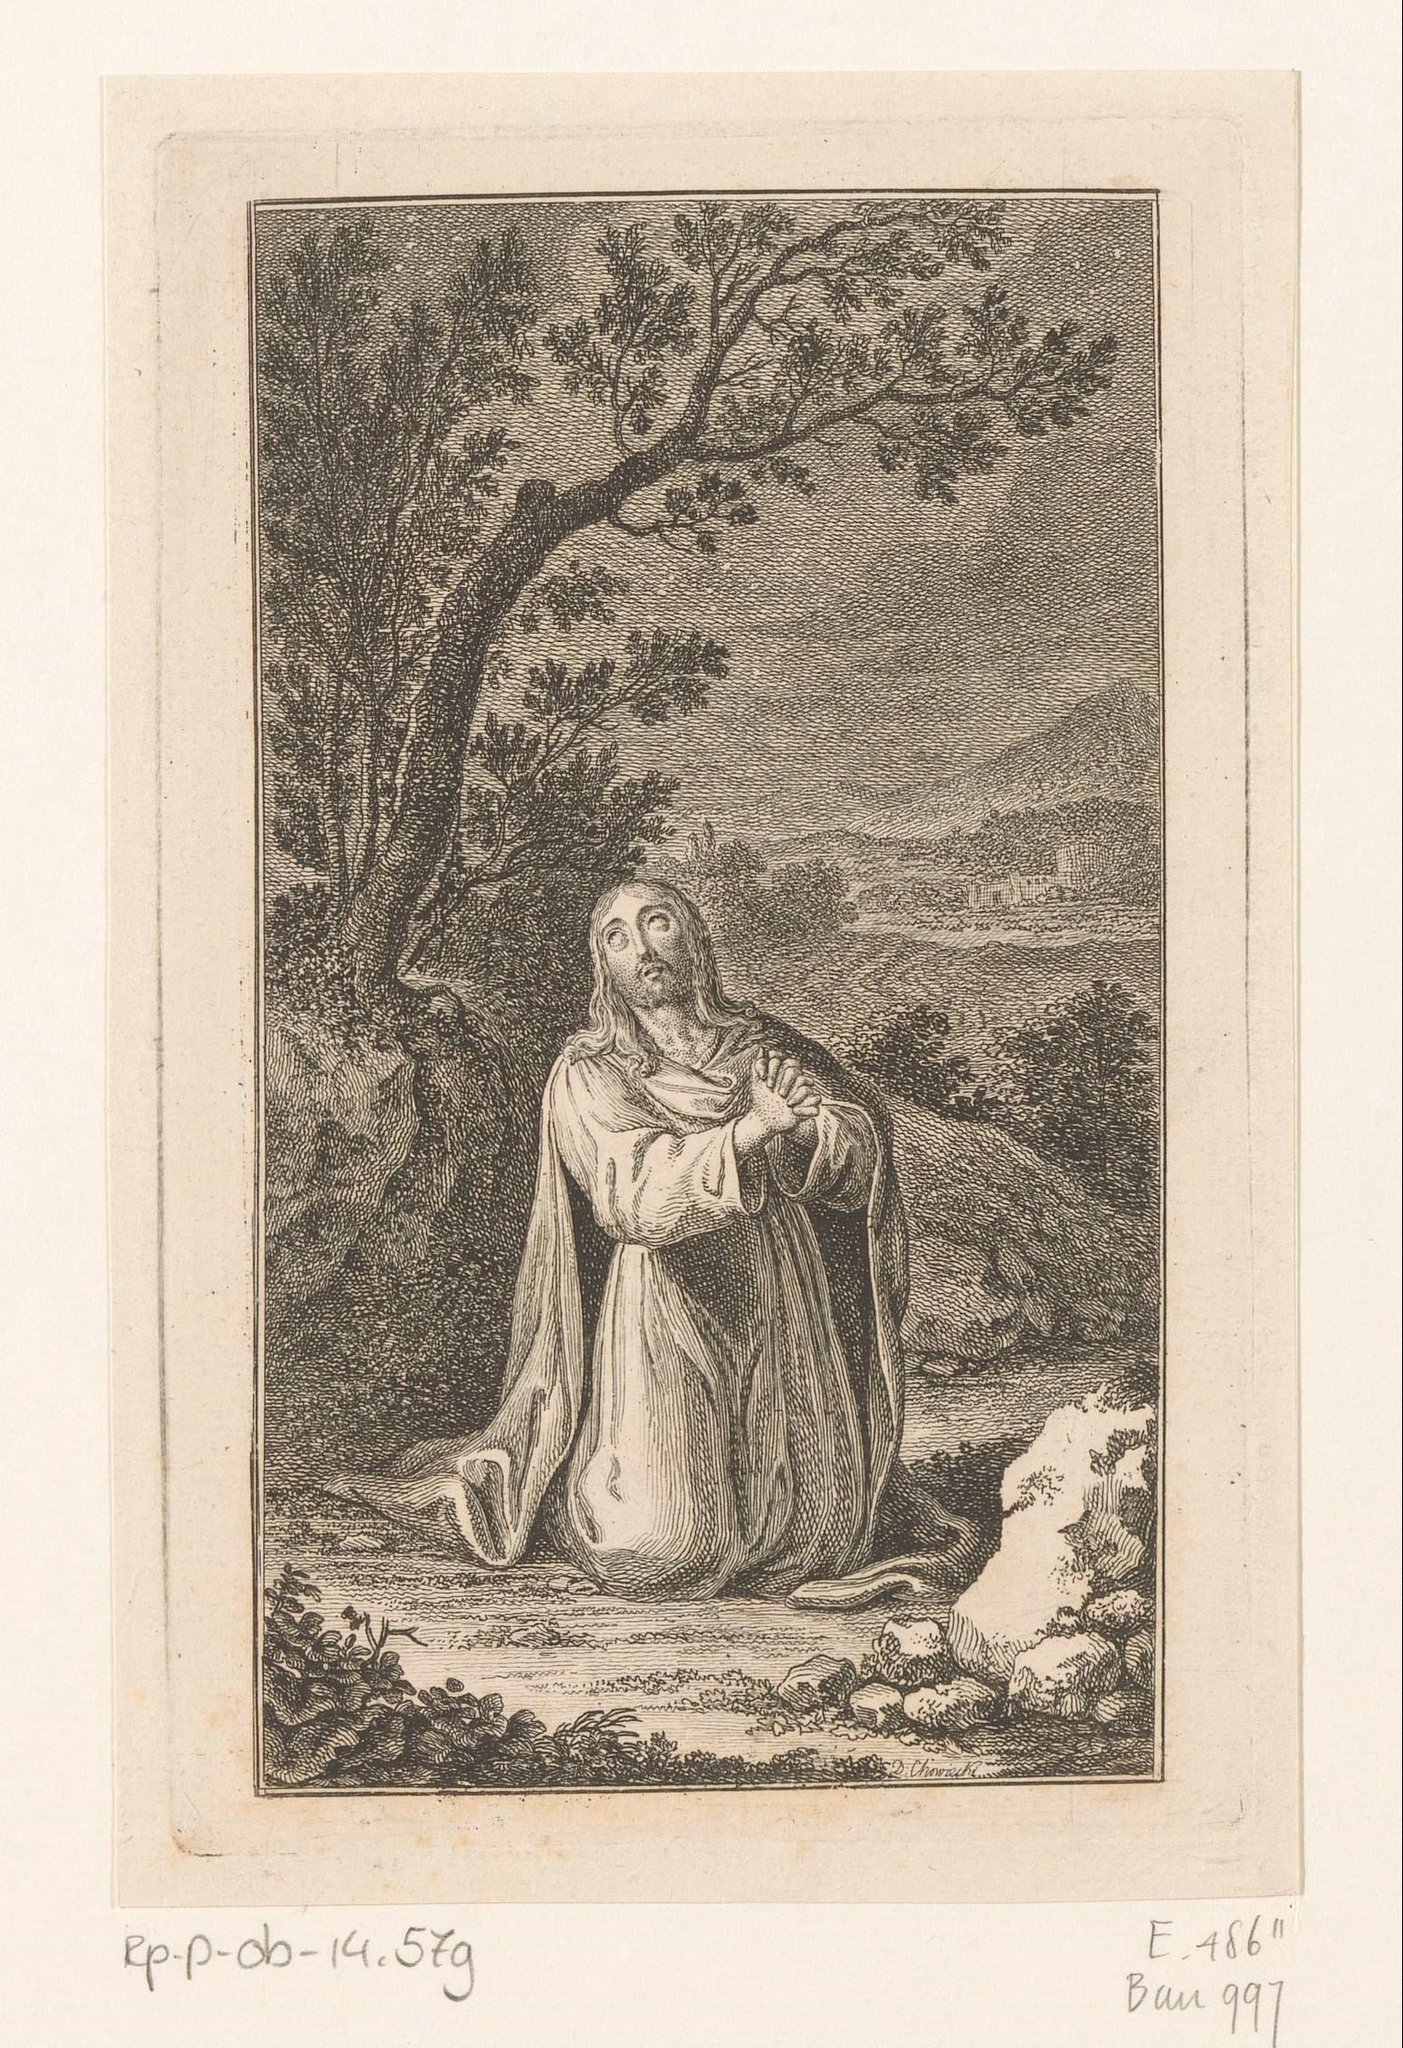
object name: print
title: Christus in het hof van Getsemane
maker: daniel nikolaus chodowiecki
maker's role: draughtsman, print maker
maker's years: 1726-1801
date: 1783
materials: paper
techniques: etching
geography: berlin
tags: johann caspar lavater, christ's prayer in the garden of gethsemane during the night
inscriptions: collector's mark: Lugt 2228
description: Prent gebruikt voor: Lavater, Johann Caspar. Jesus Messias, Oder die Evangelien und die Apostelgeschichte in Gesängen. 4 dln. Winterthur: s.n., 1784, dl. 2.